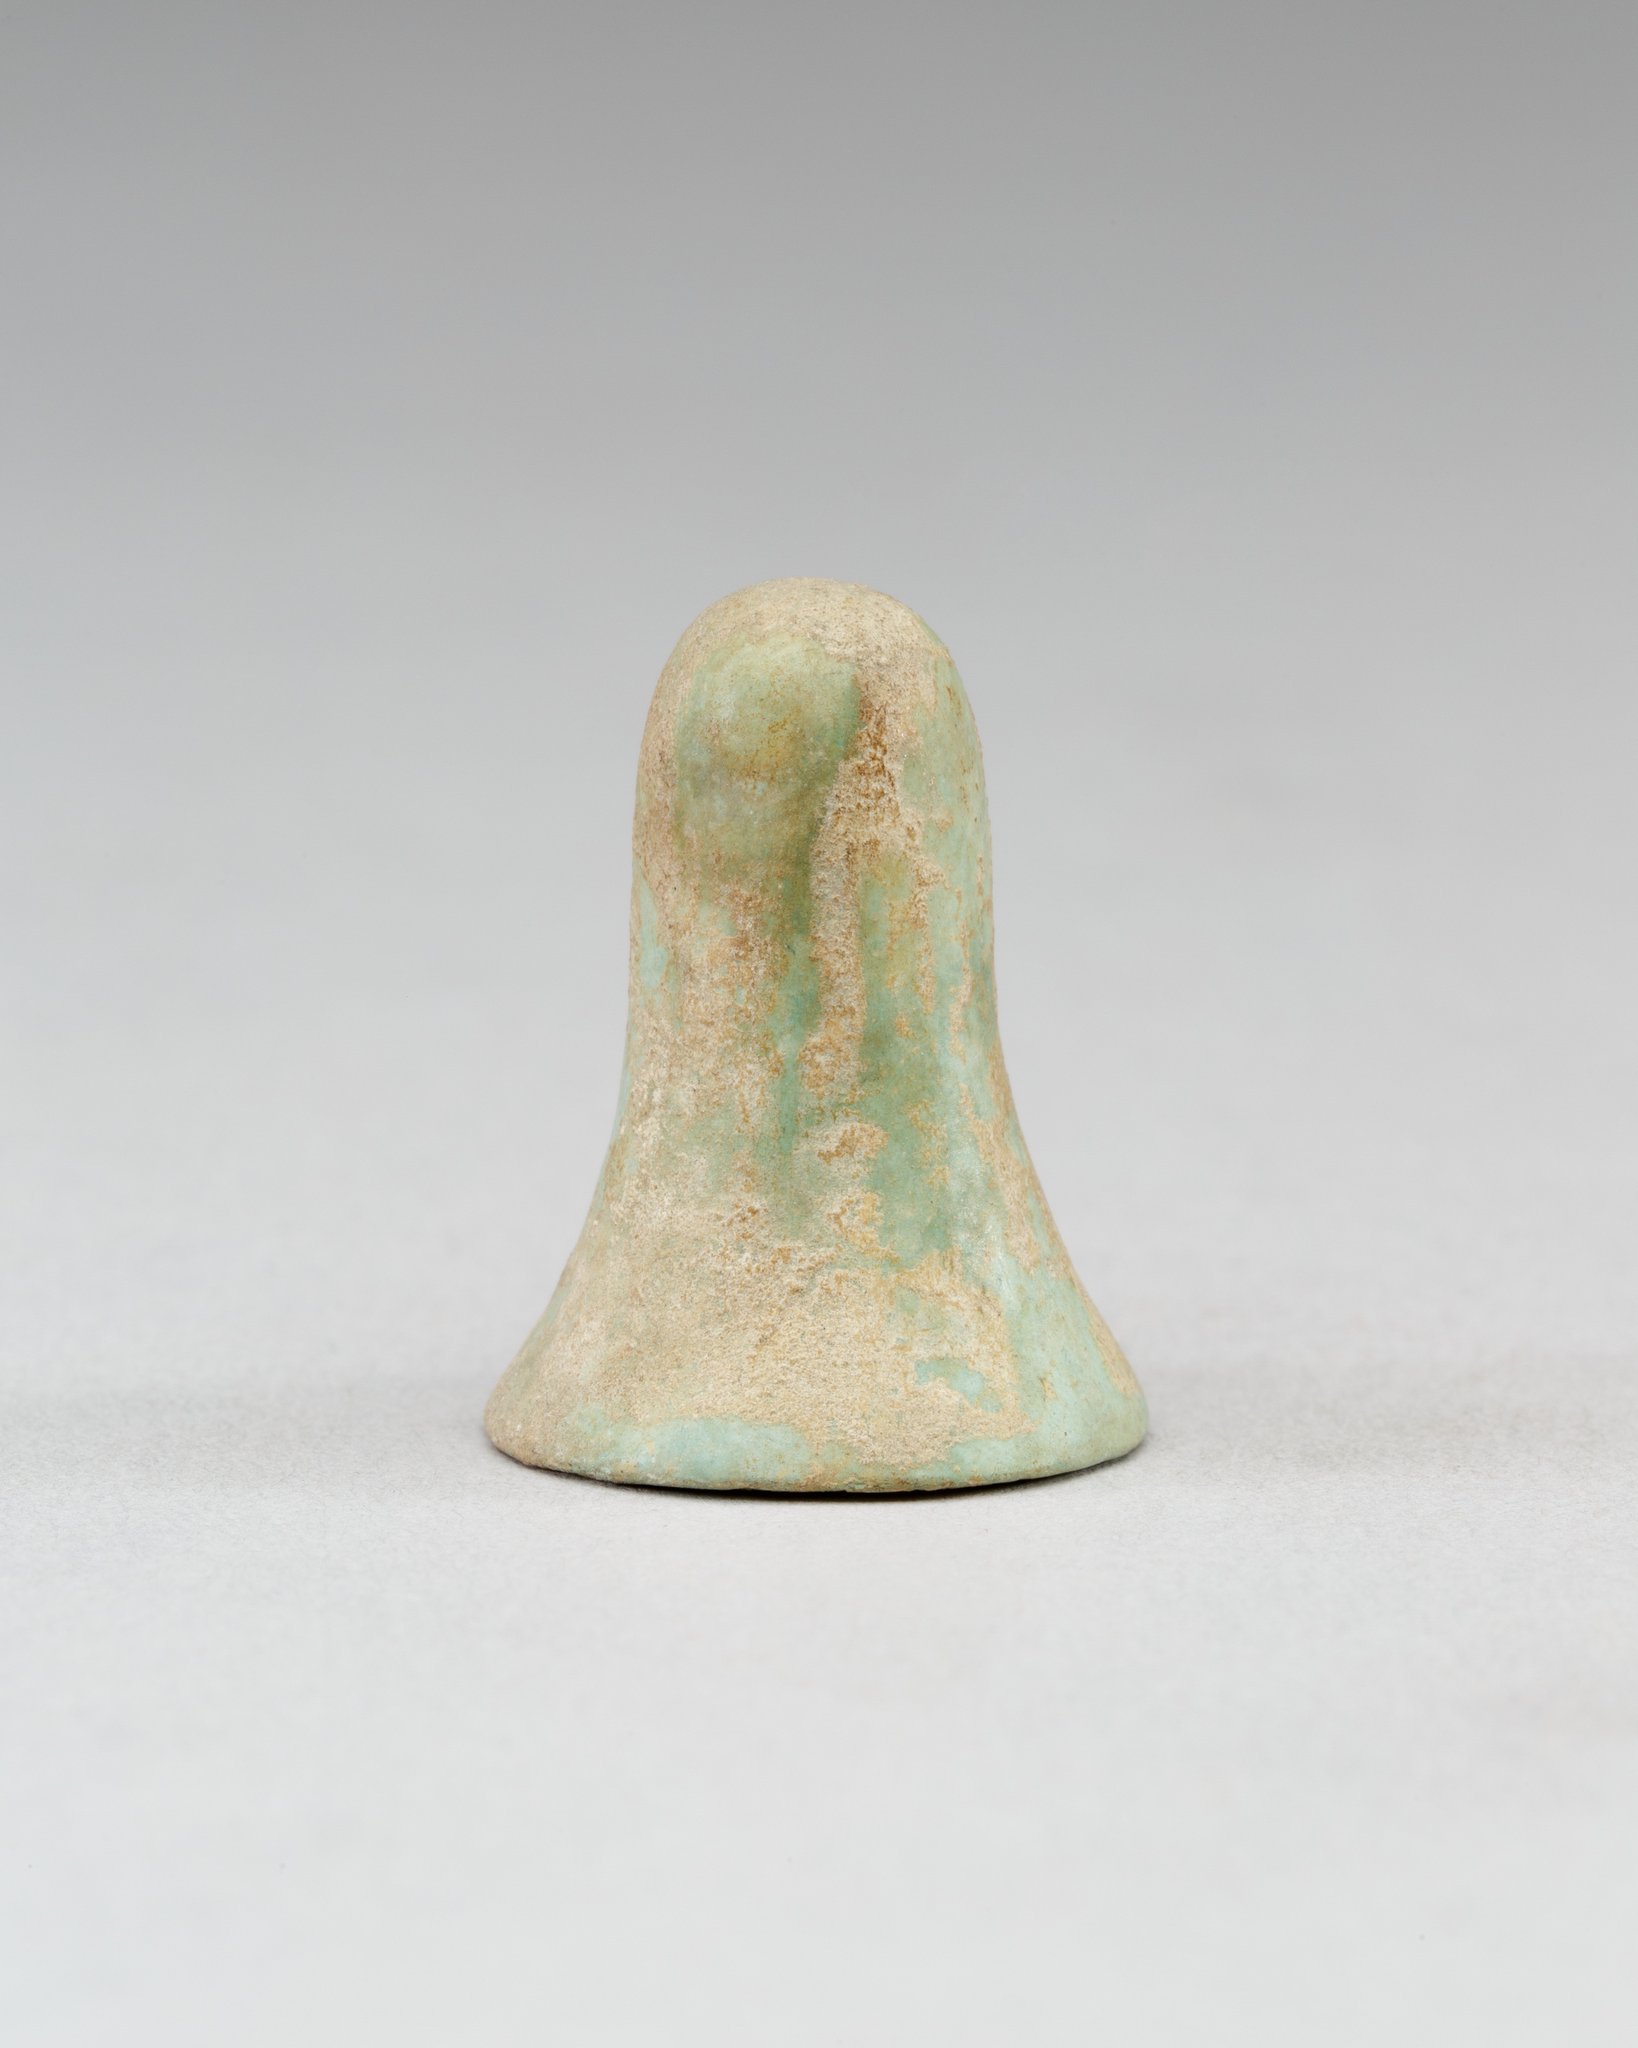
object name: game piece, conical, burial 8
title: Conical Gaming Piece from Neferkhawet's Tomb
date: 1504-1447 BCE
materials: faience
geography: egypt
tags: games